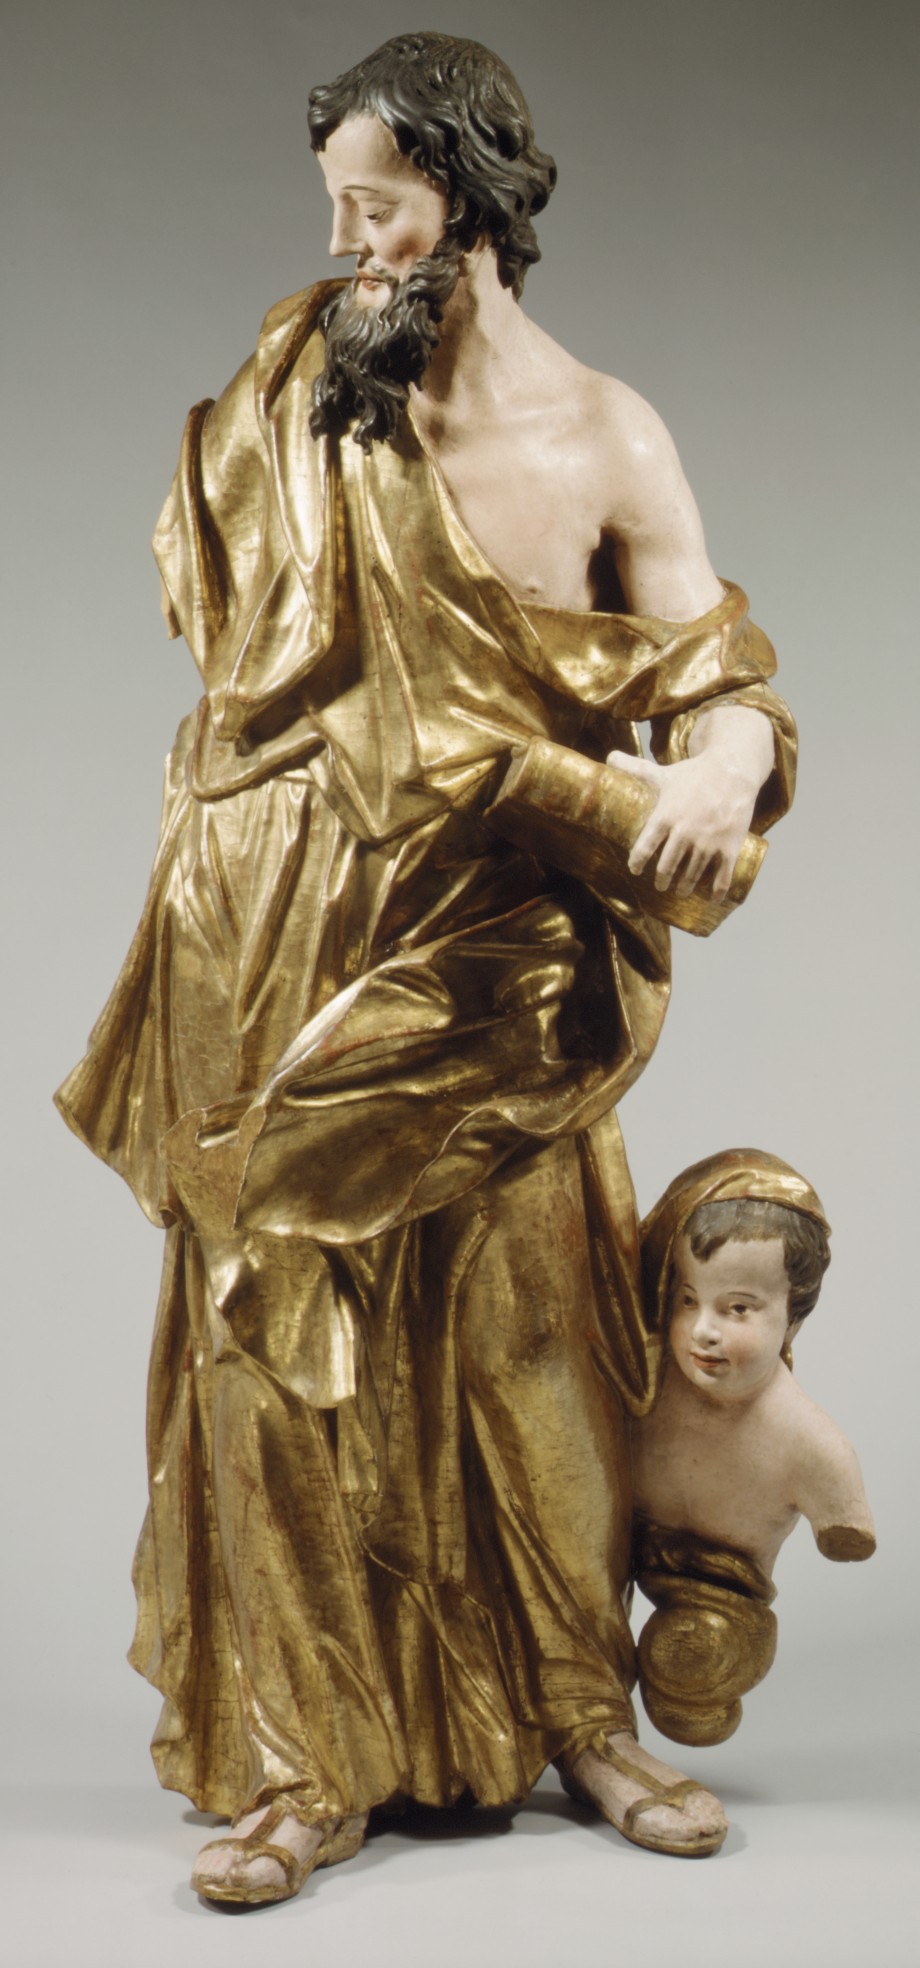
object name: statue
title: Saint Matthew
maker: johann georg libigo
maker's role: artist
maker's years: 1690-1729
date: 1667-1733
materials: wood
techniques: gilding, polychrome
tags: children,saint matthew